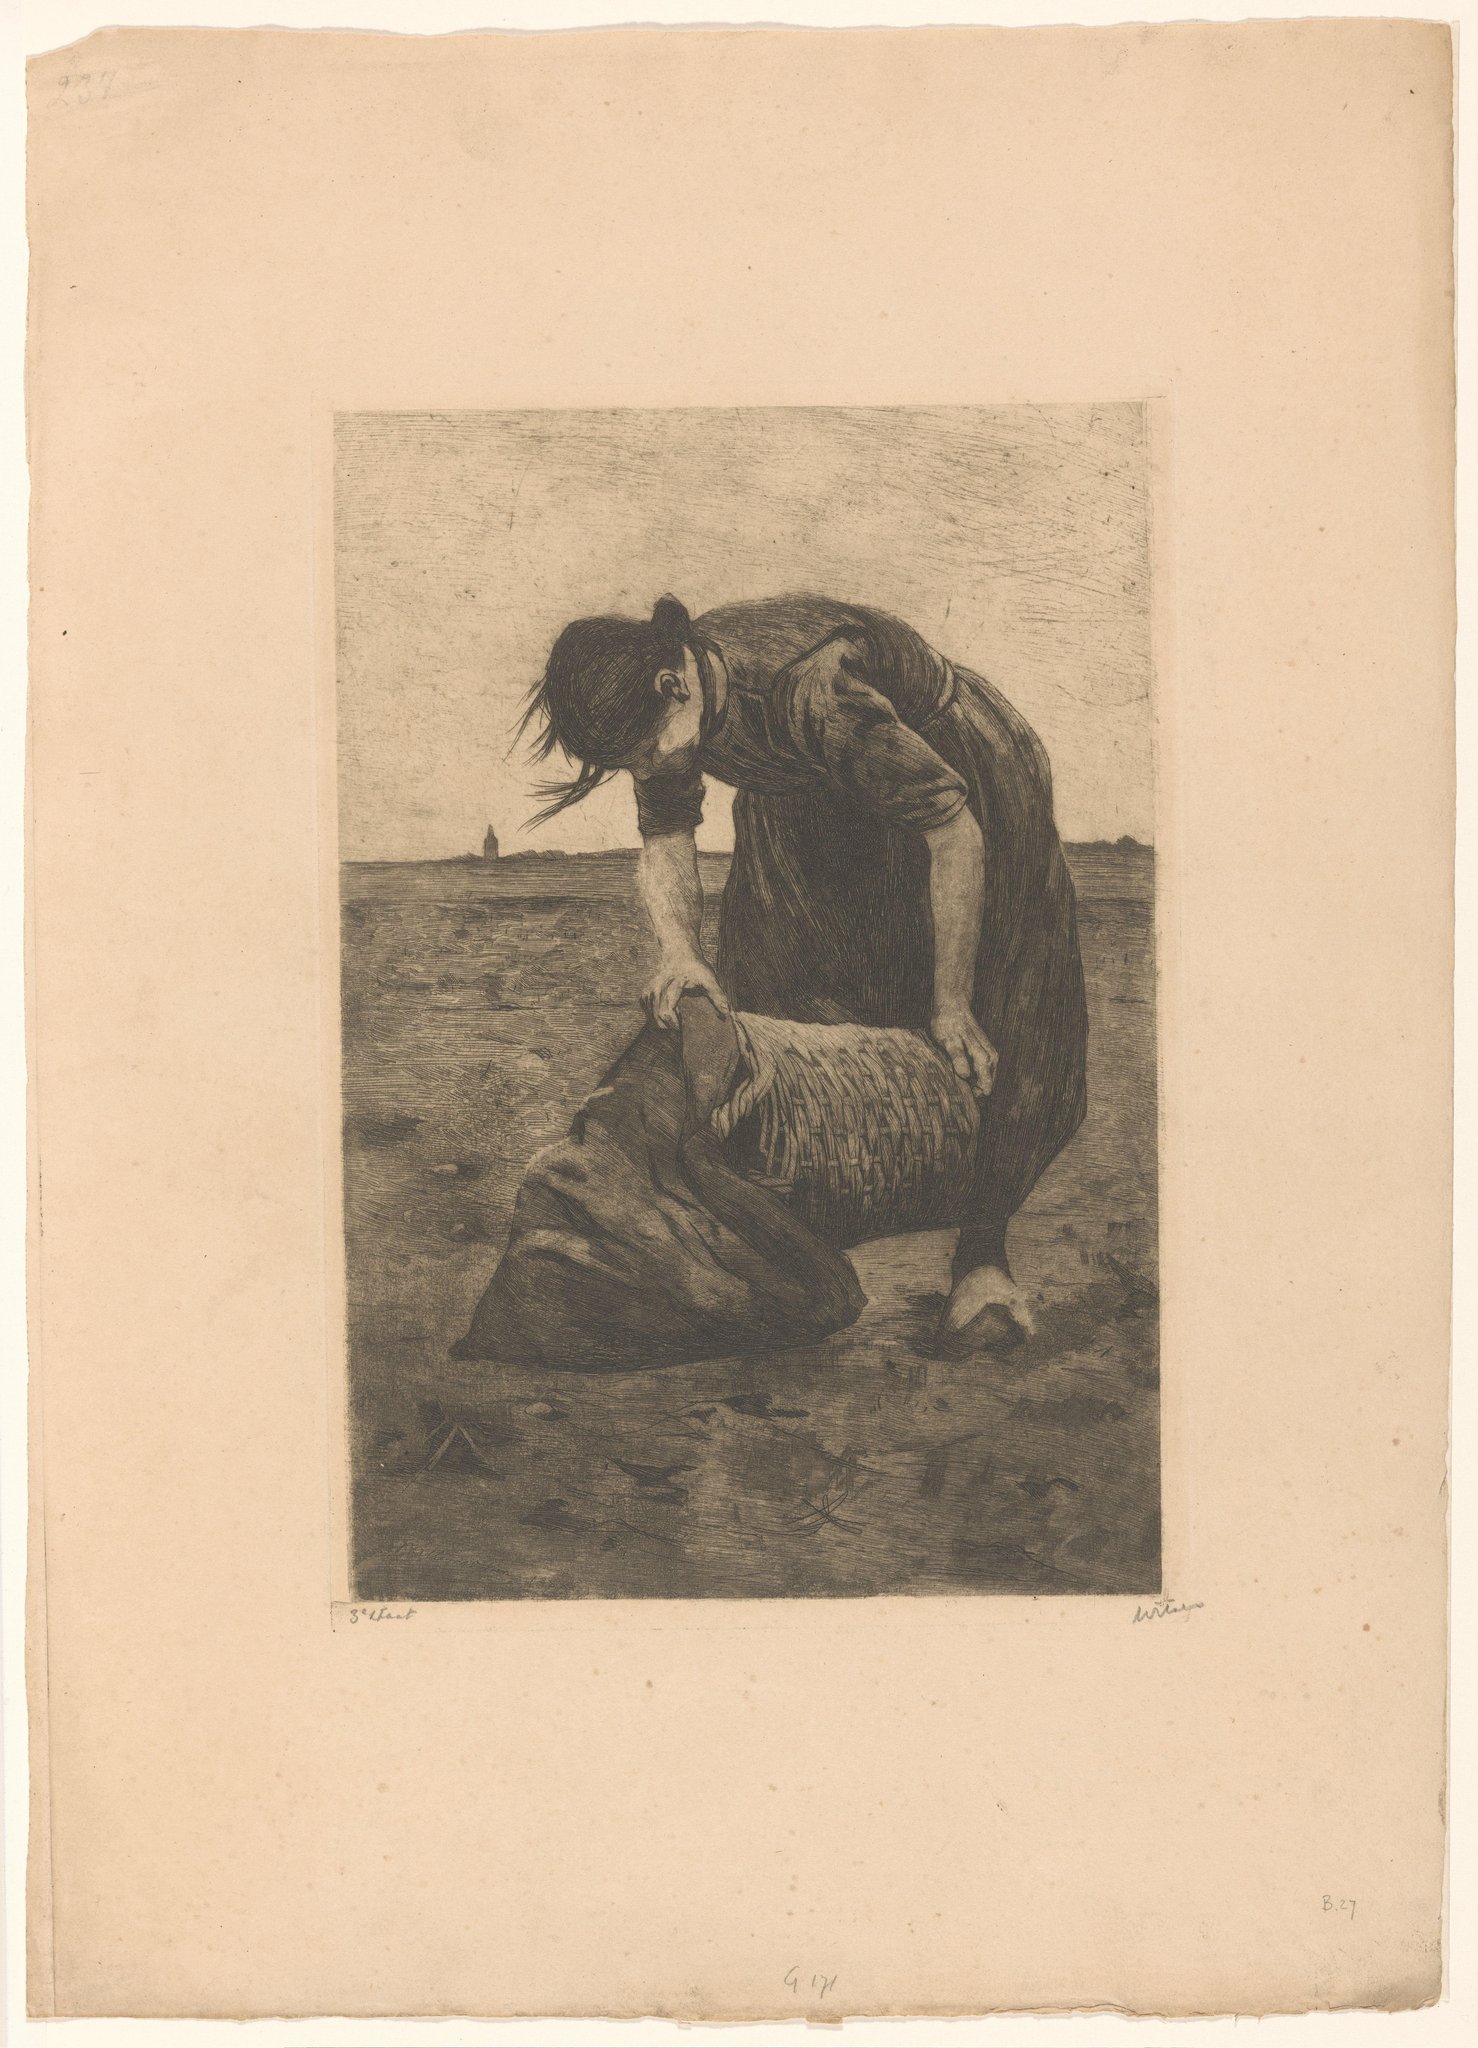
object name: print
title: Voorovergebogen aardappelrooister met een mand en zak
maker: willem witsen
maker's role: draughtsman, painter, print maker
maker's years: 1860-1923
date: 1886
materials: paper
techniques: etching, intaglio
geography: ewijkshoeve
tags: harvest, farmers - aa - female farmer, farmer's wife, potatoes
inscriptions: collector's mark: Lugt 2228, inscription: ‘3e staat’, signature: ‘Witsen’